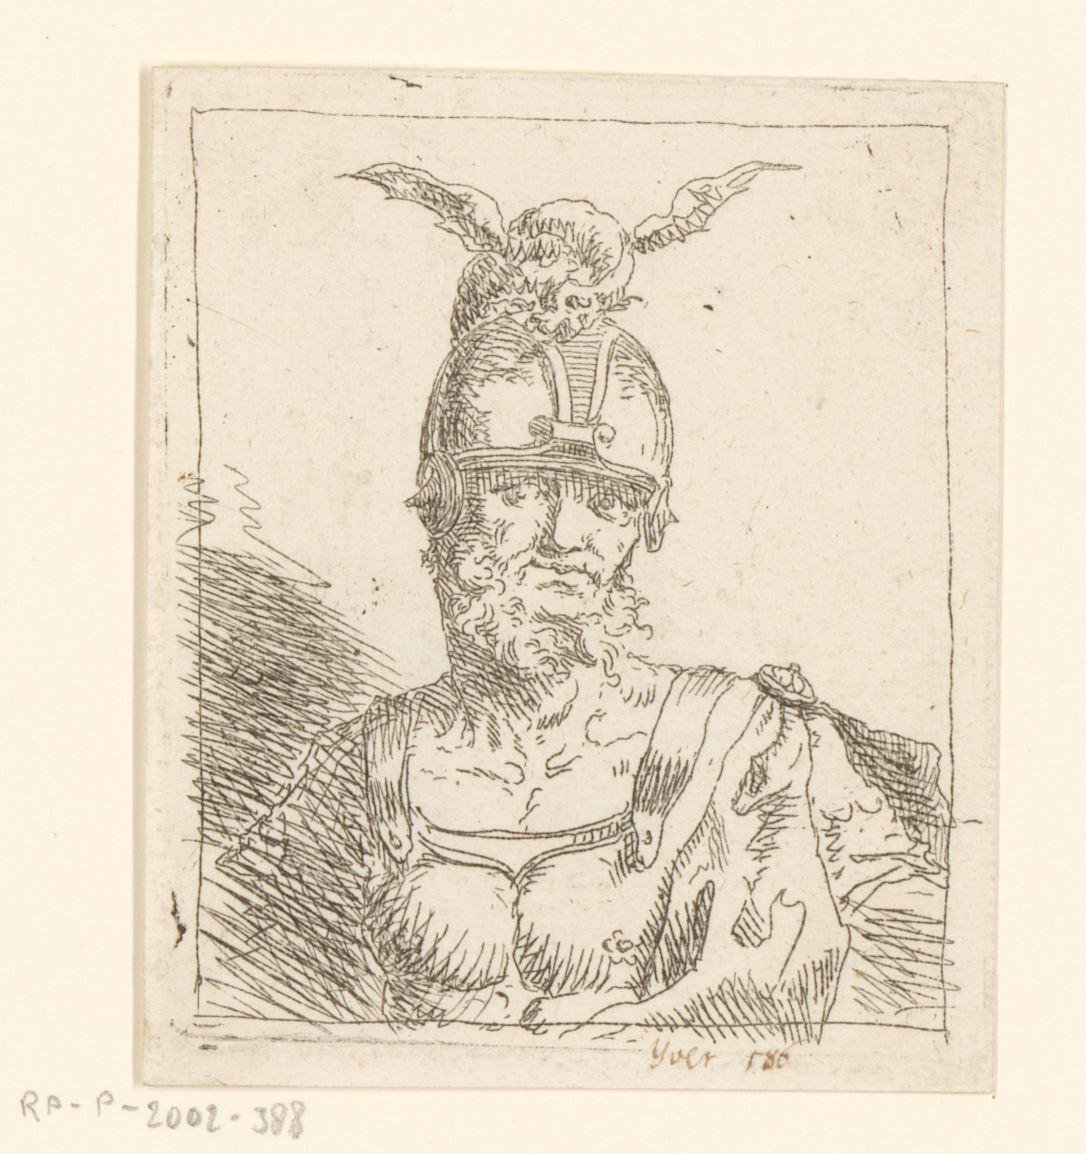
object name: print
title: Buste met harnas en helm, naar voren gericht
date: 1619-1683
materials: paper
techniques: etching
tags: armour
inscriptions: inscription: ‘Yver 586’, collector's mark: Lugt 2228, collector's mark: Lugt 2760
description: Op de helm van de geharnaste man zit een draak.